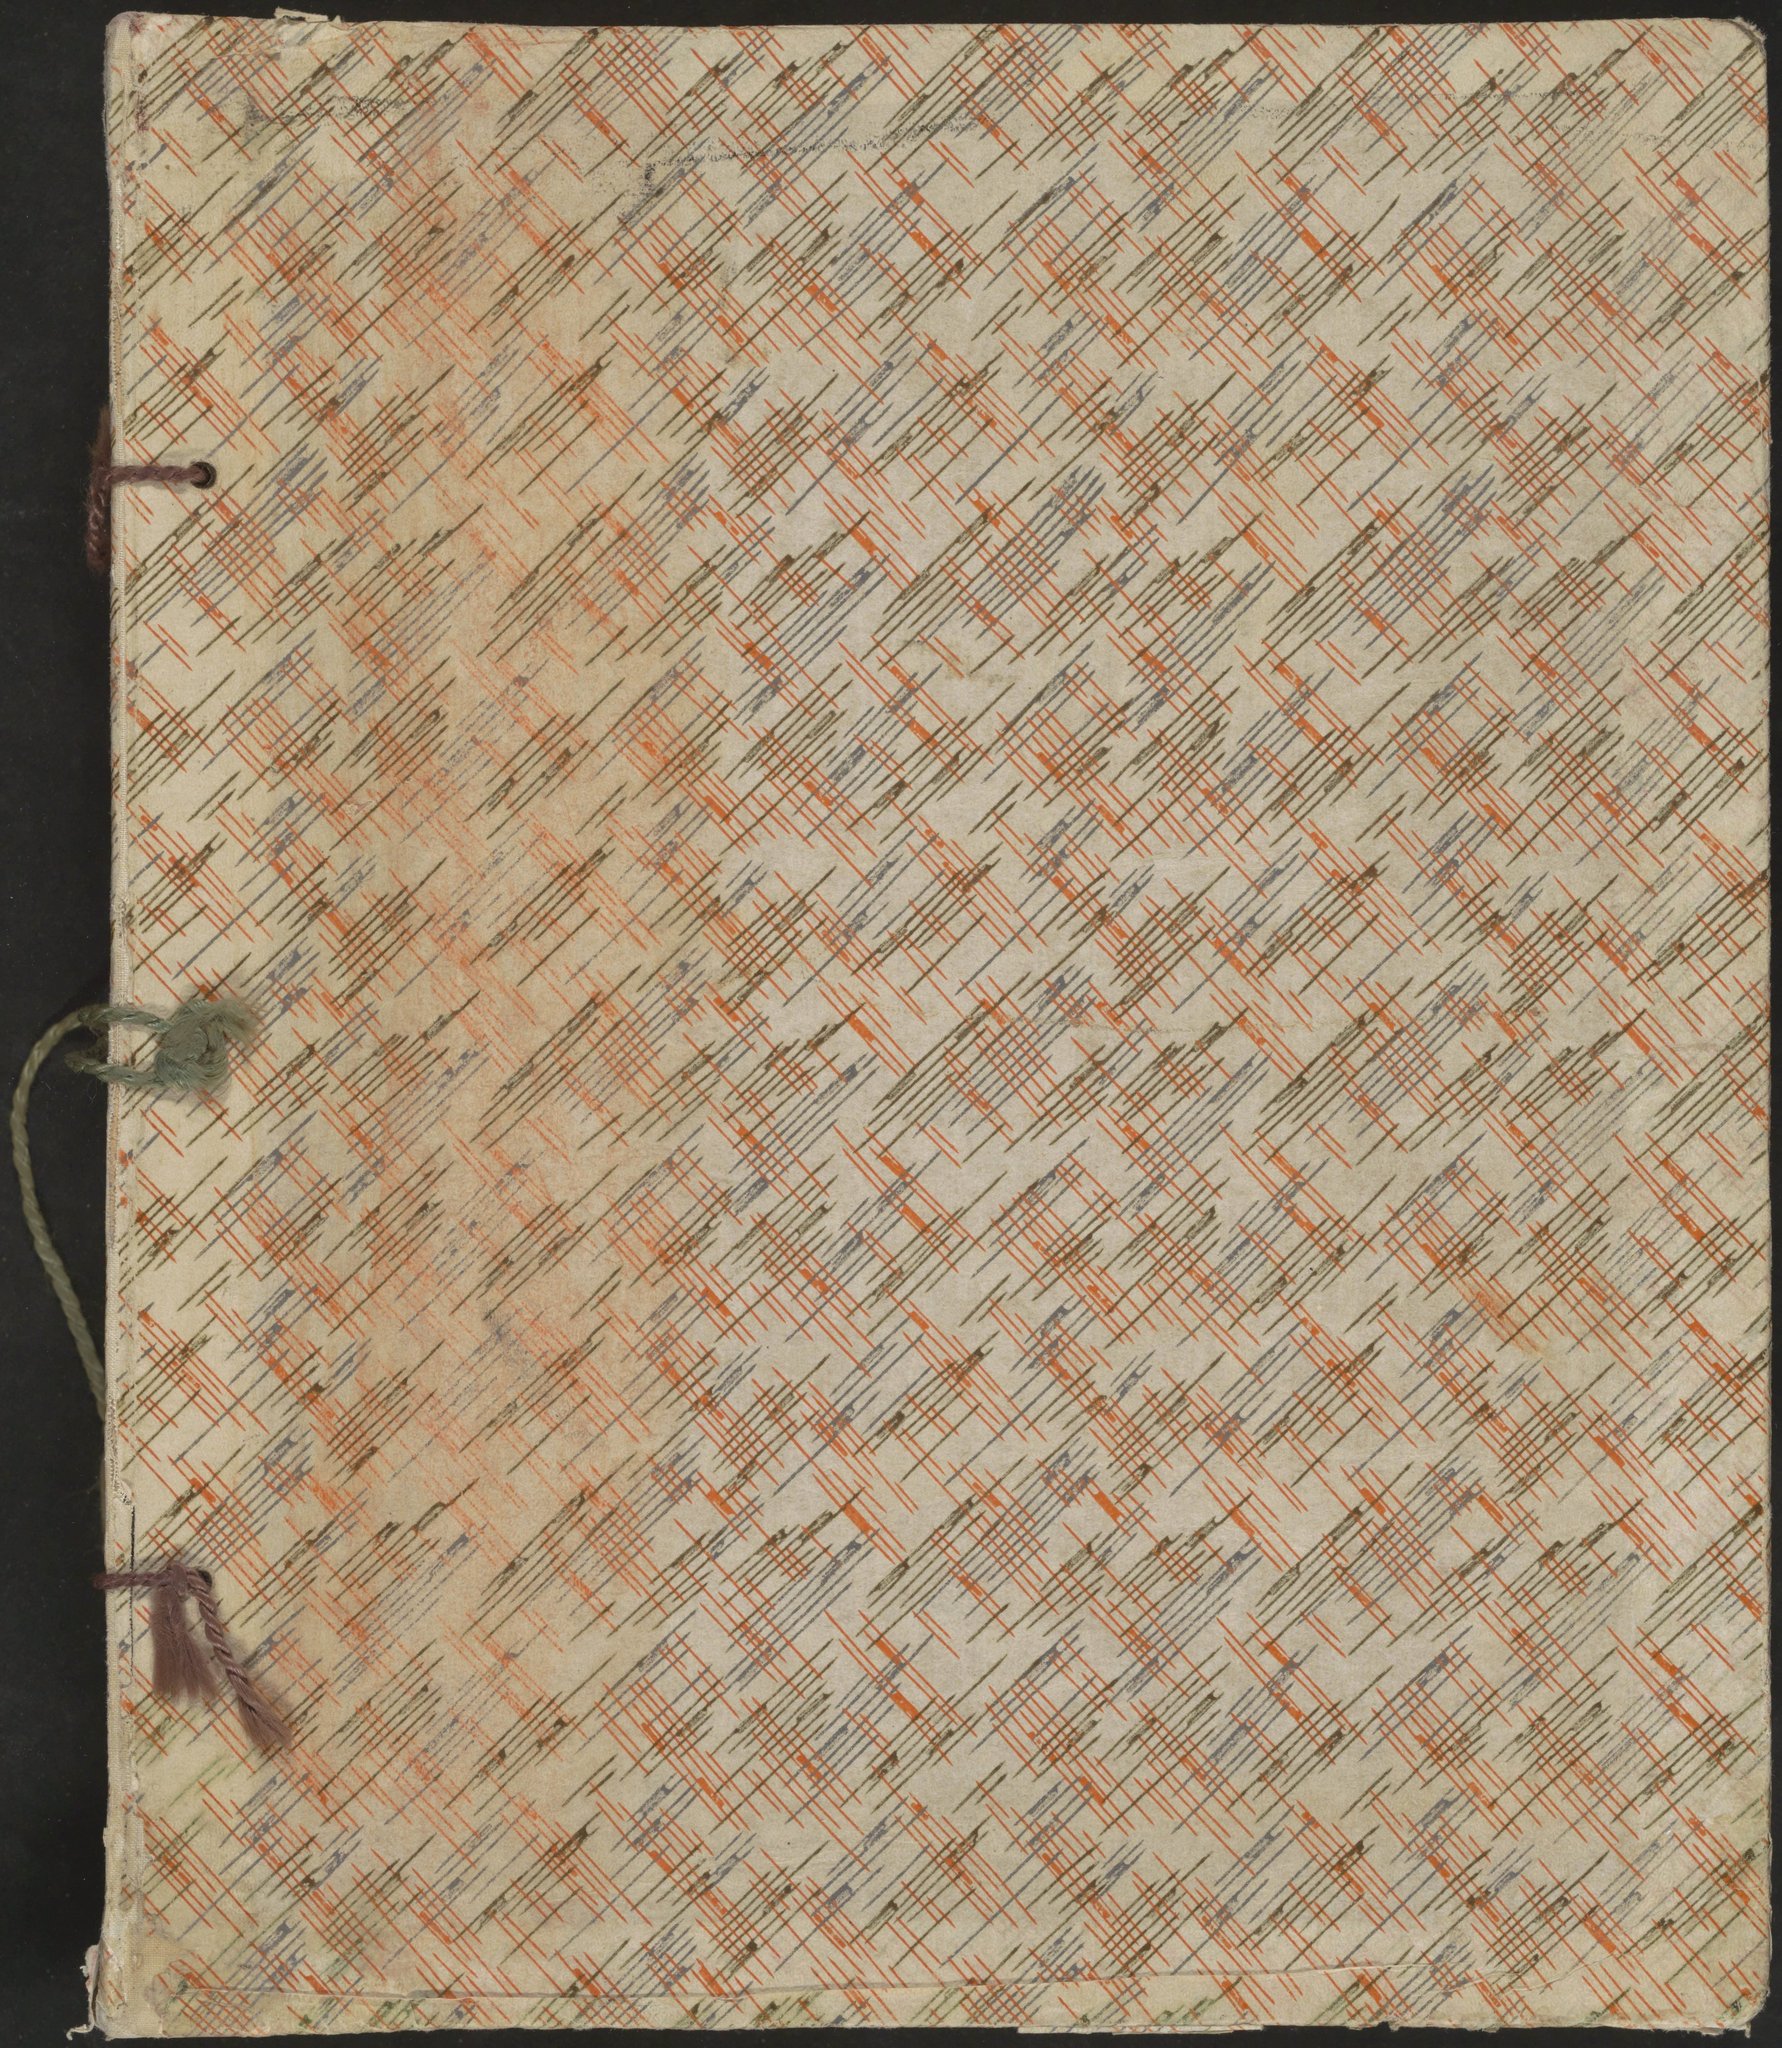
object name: scrapbook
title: Private and Collector’s Albums with Quick Photos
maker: Anonymous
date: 1891-1943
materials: cardboard, linen, paper, photographic support, fiber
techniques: albumen print, gelatin silver print, photoaquatint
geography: western europe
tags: amsterdam, portrait of a musician, family life, netherlands, germany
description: All kinds of large and small special collector’s albums were in circulation for quick photos of family members and friends. Quick photos are also regularly found among other pictures in family albums.